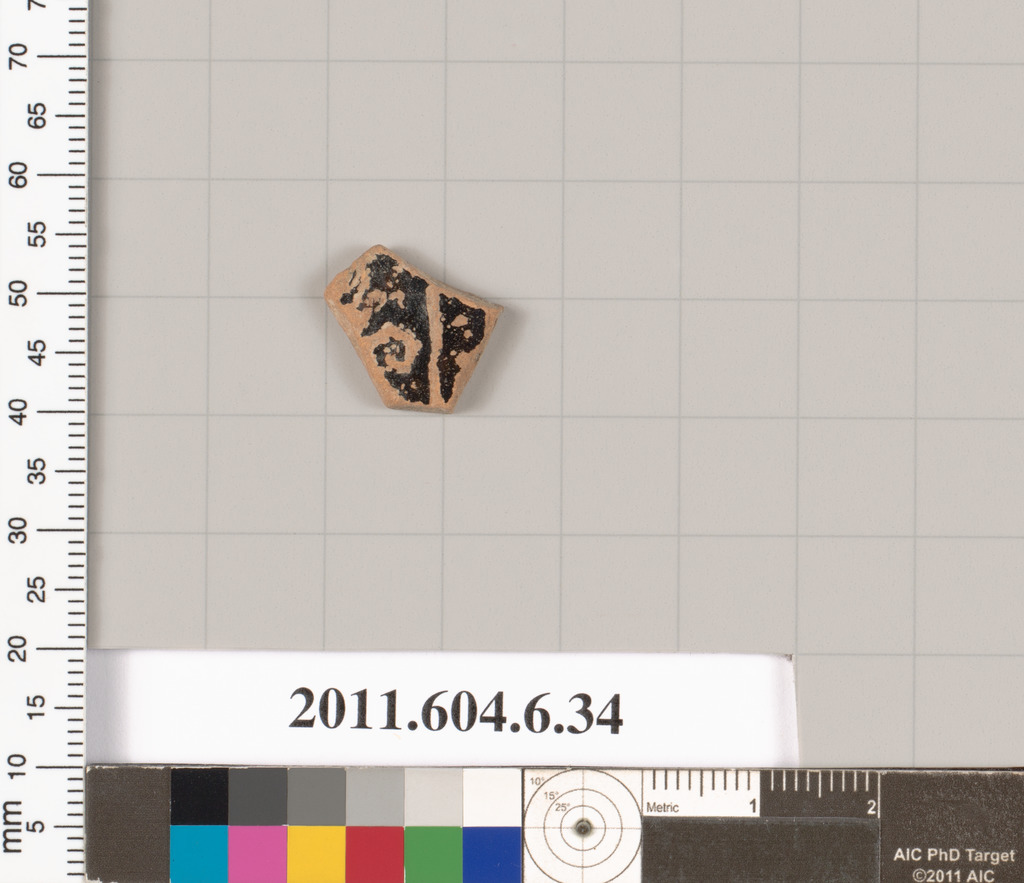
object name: undetermined open shape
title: Terracotta fragment of an open shape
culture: greek, attic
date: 375-325 BCE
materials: terracotta